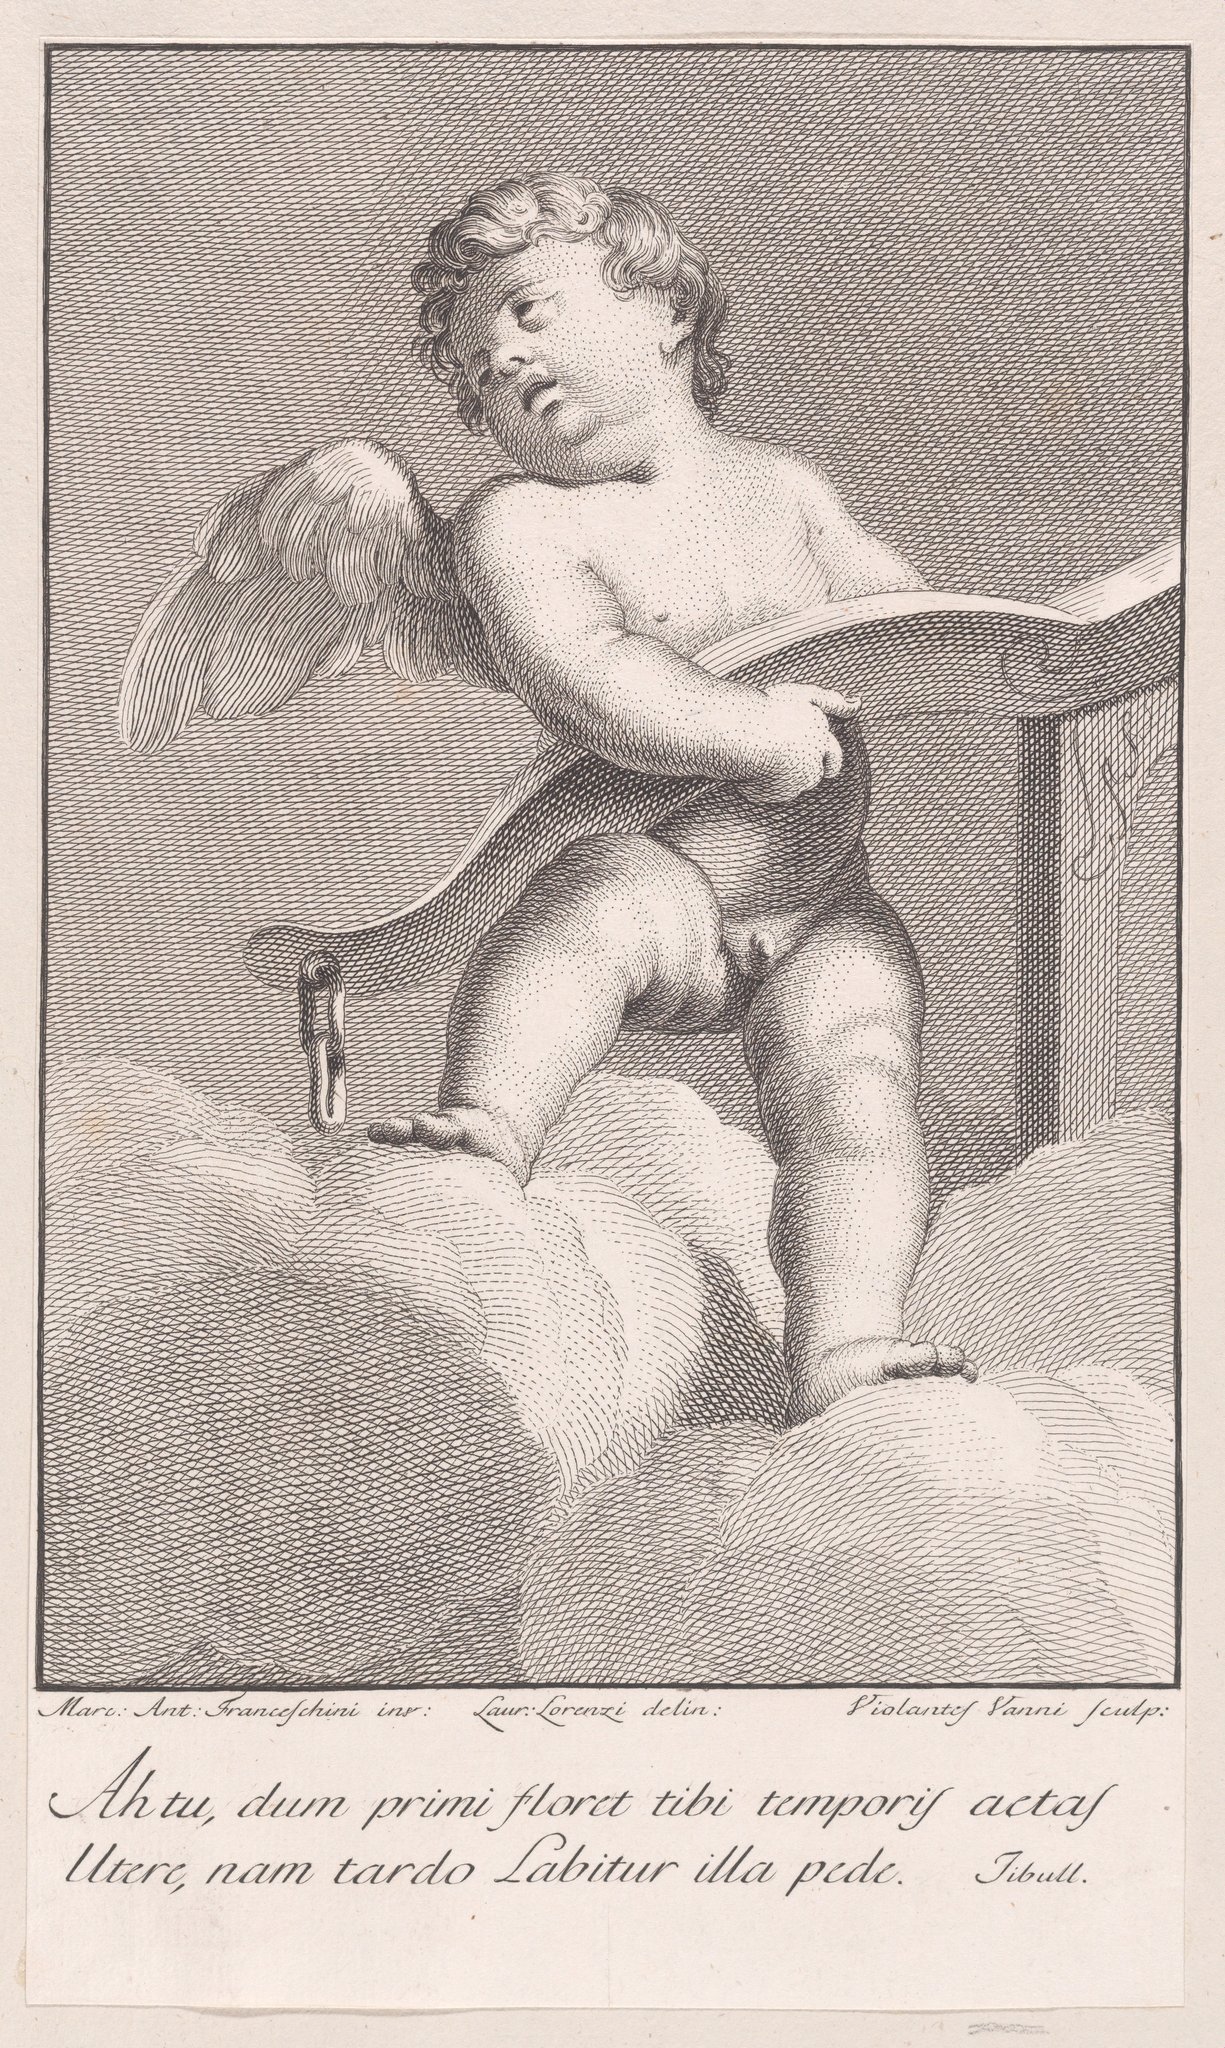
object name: print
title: Putto with a yoke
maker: violante vanni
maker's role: artist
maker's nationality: italian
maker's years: 1732-1776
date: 1774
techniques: engraving, etching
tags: putti